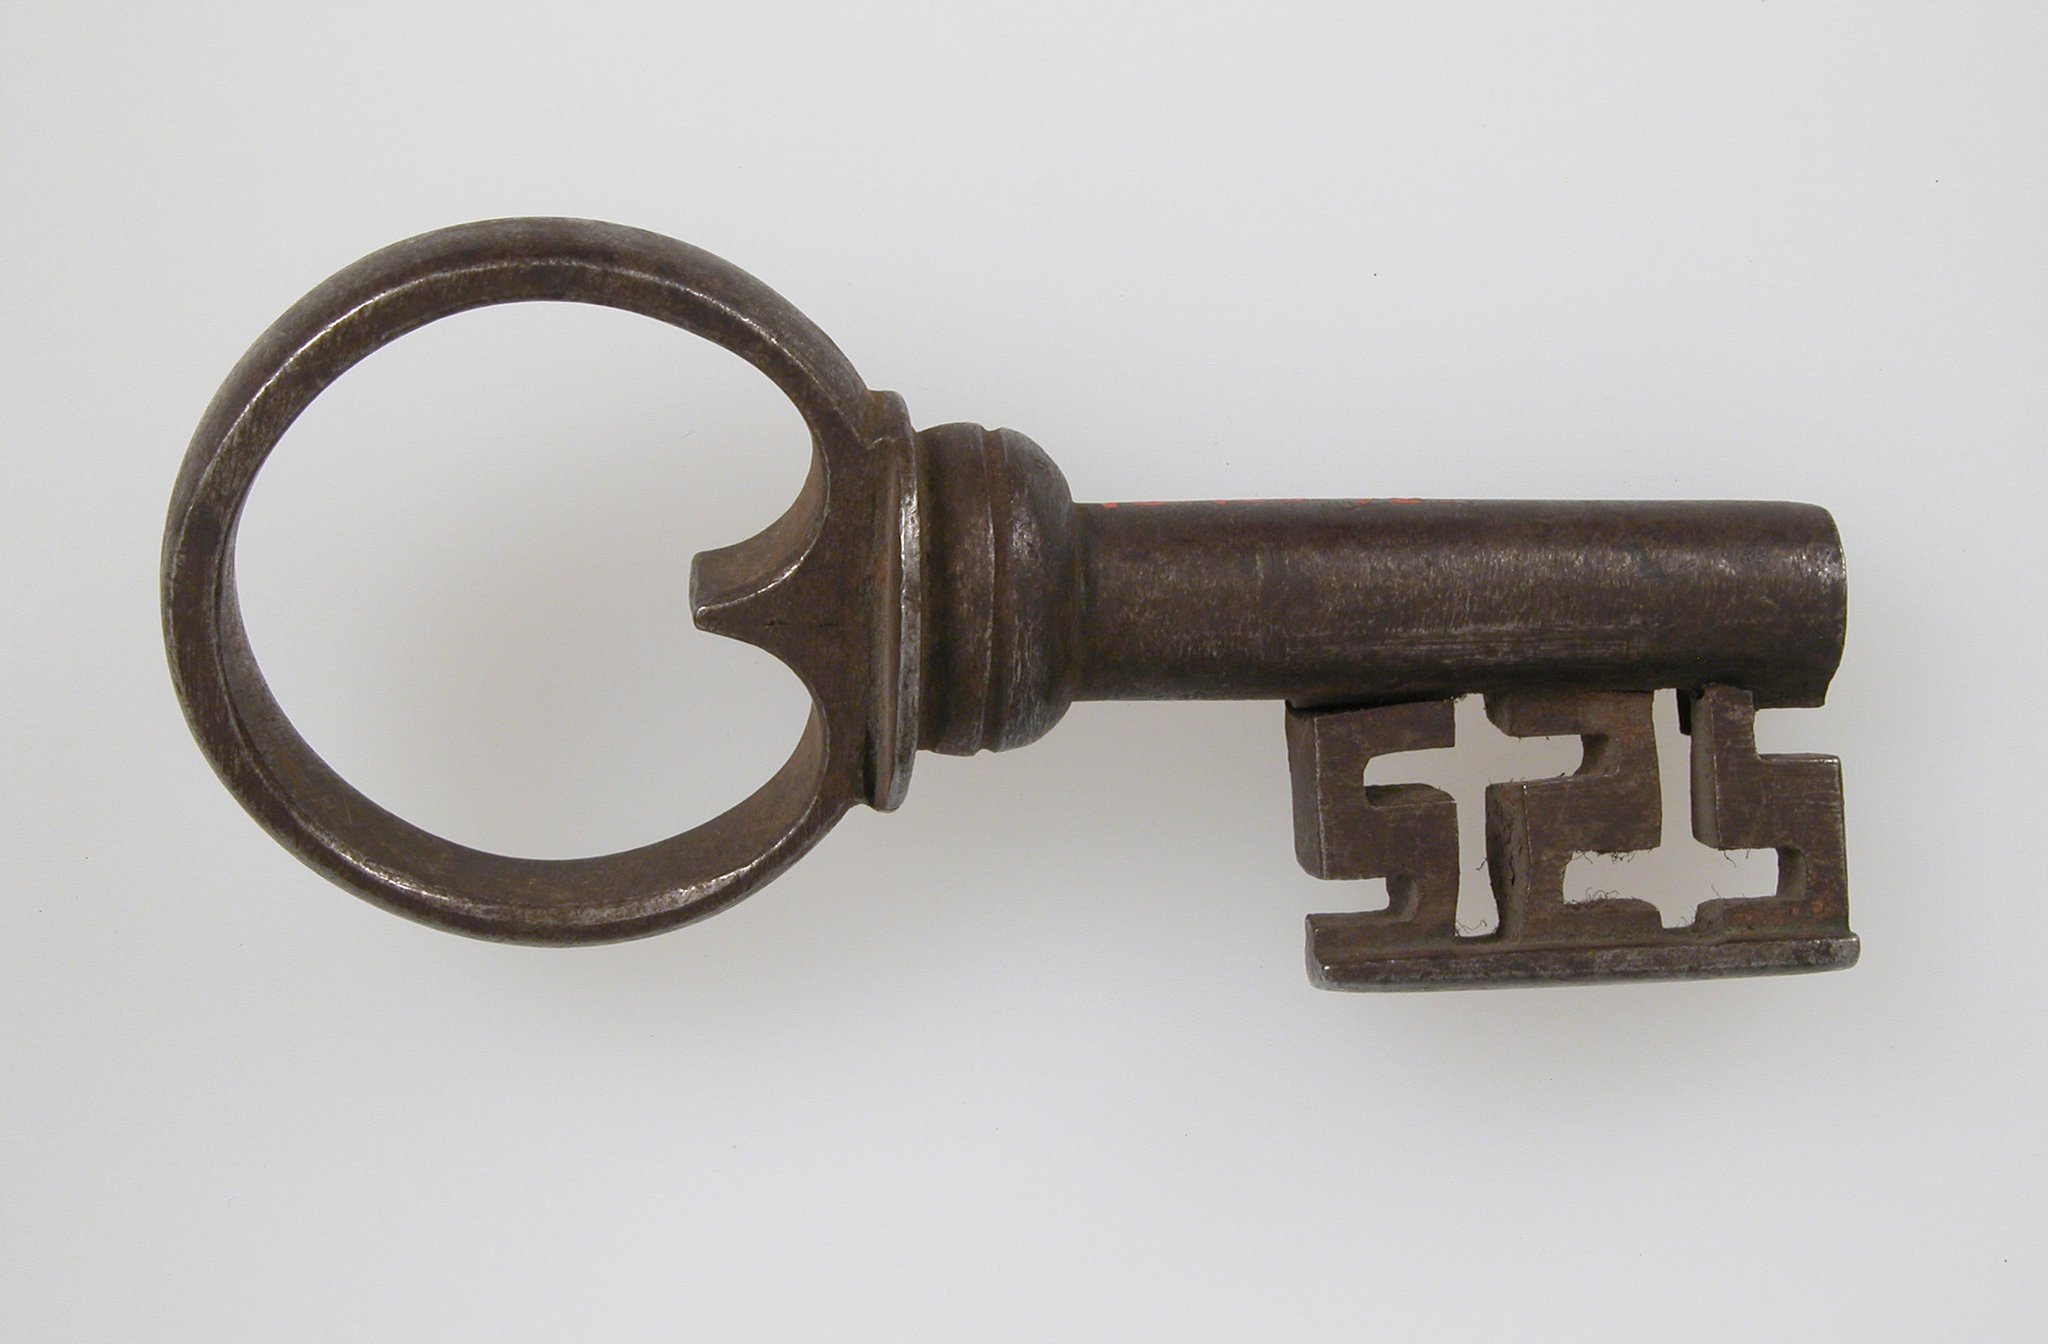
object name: key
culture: german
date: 1401-1500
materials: iron